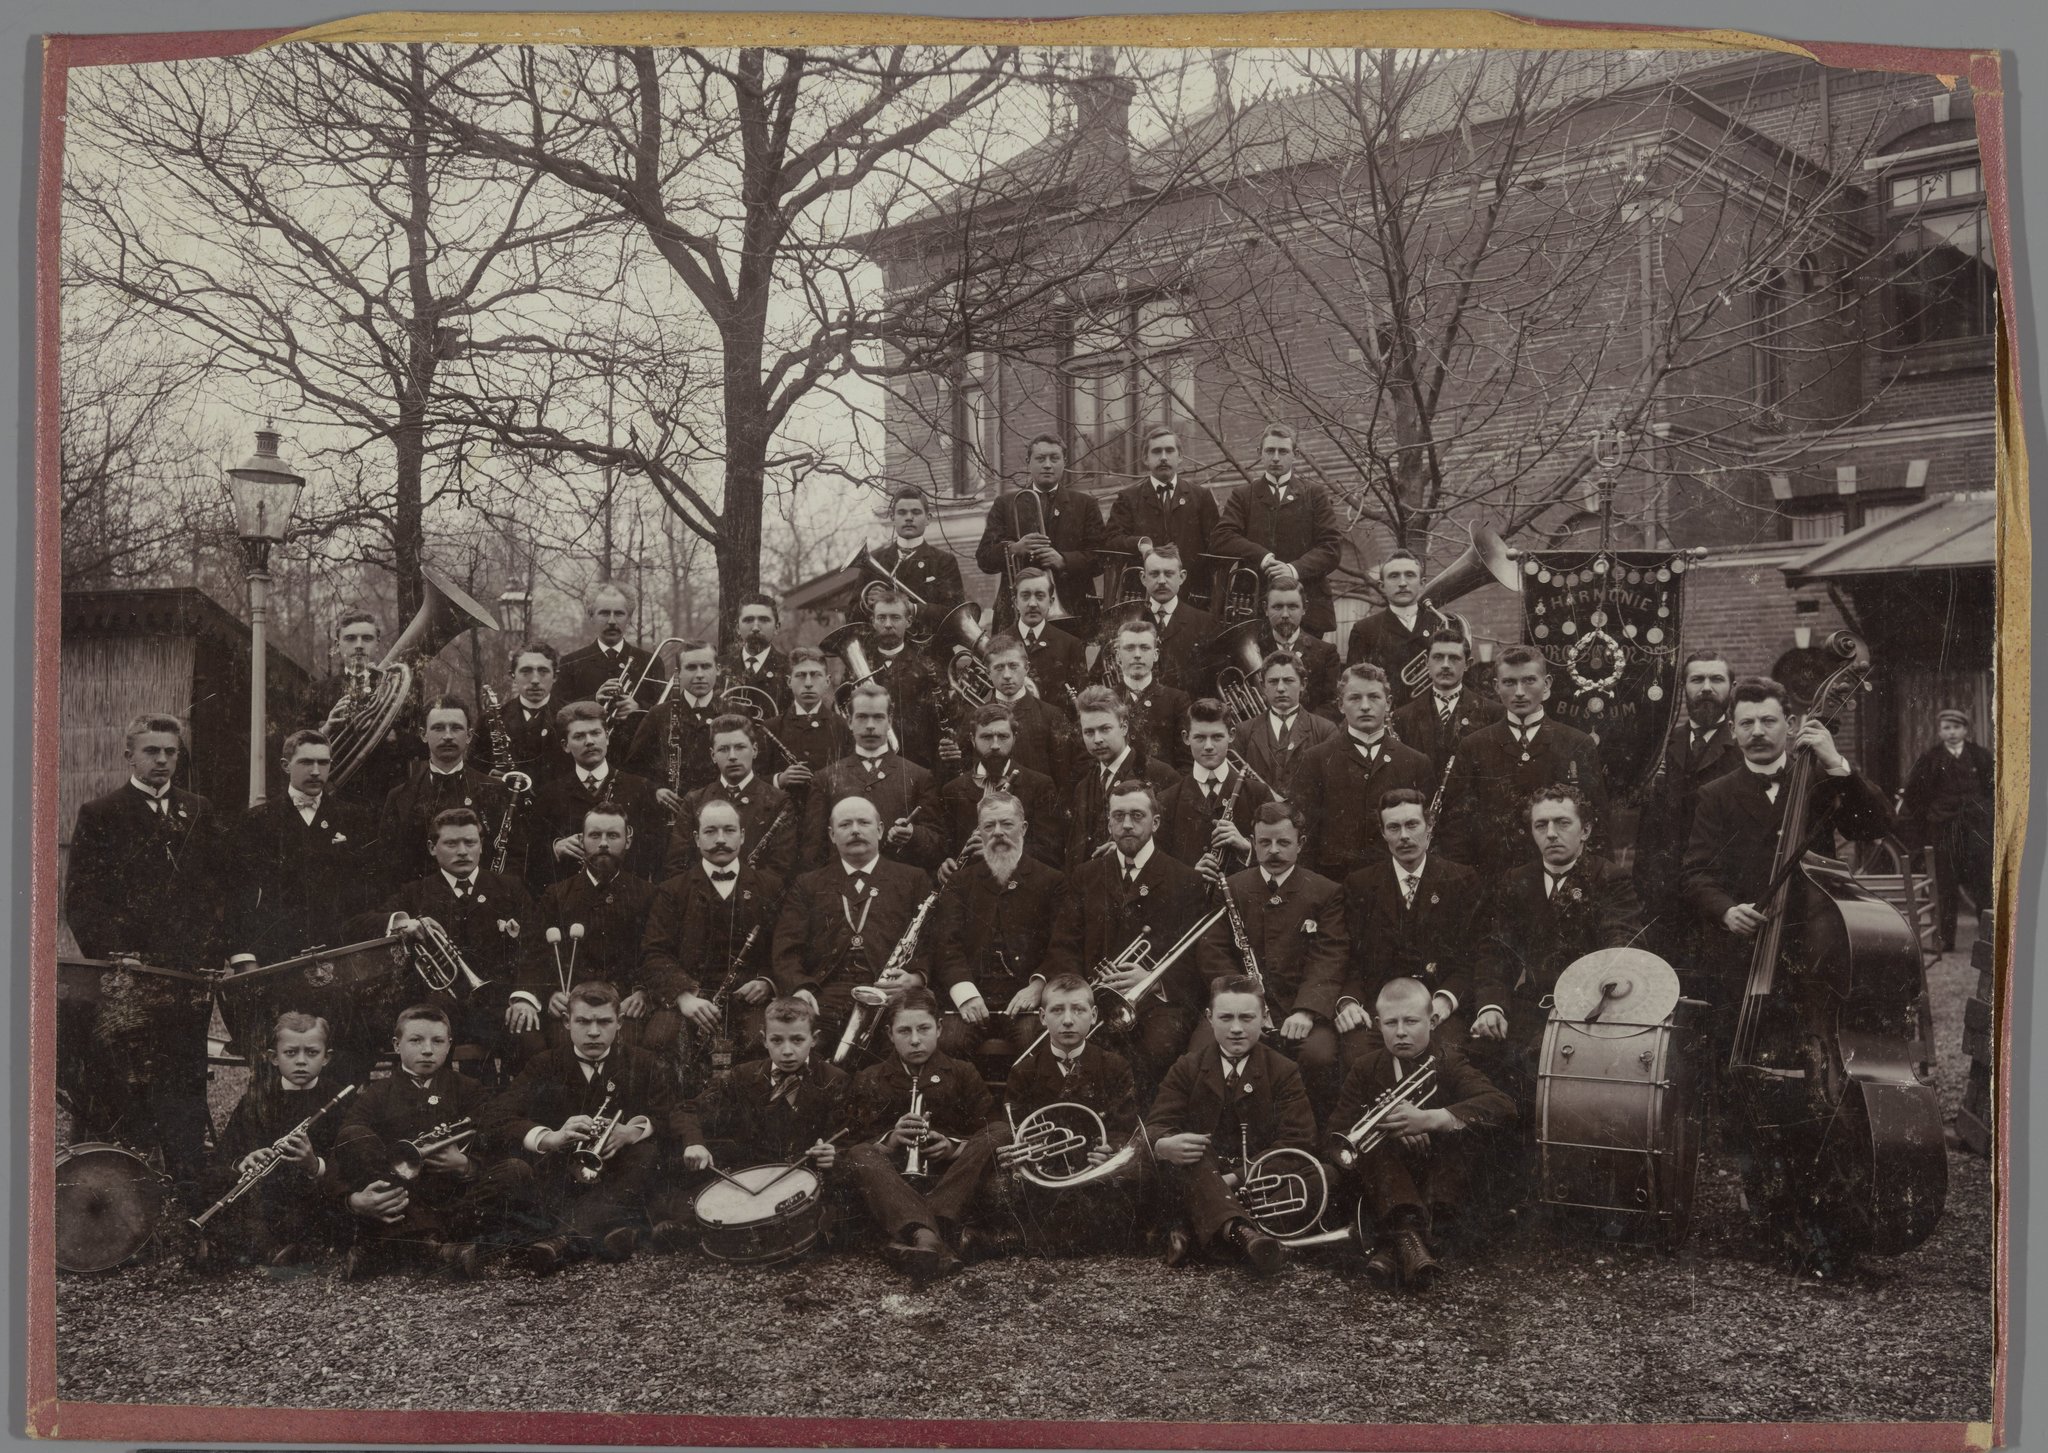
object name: photograph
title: Groepsportret van harmonie 'Crescendo'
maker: Anonymous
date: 1900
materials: cardboard, photographic support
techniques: collodion silver print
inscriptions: inscription: ‘eigendom van P.J.F. Vermeulen Keizer Ottostraat 69 Bussum’